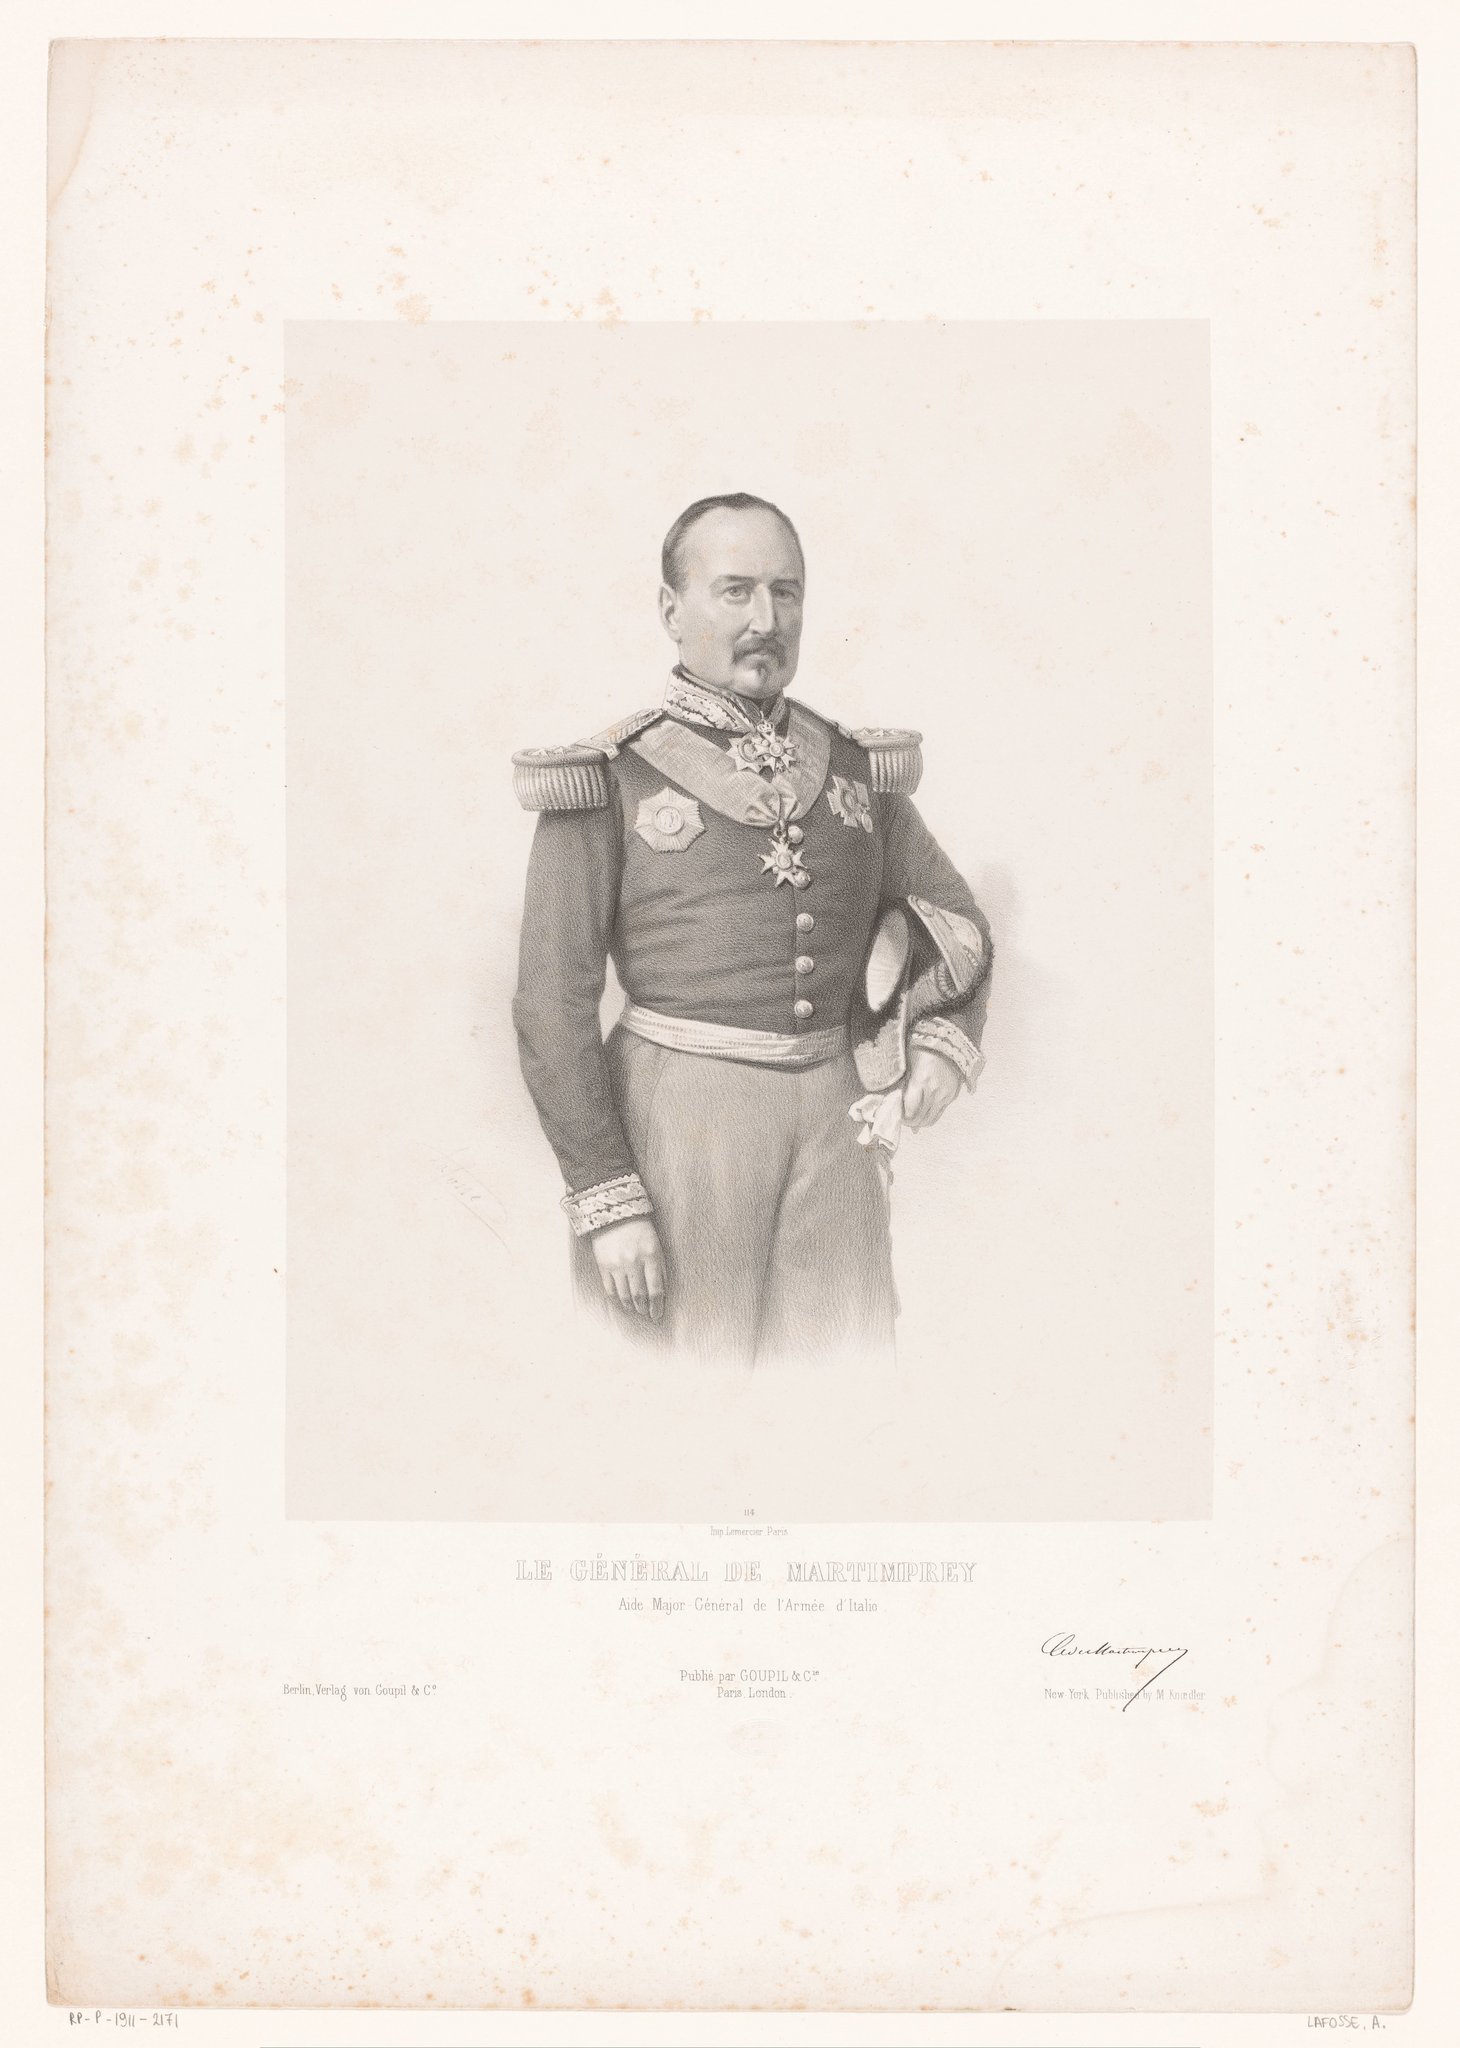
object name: print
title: Le Général de Martimprey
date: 1859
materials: paper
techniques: lithograph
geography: paris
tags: paris, politician, historical persons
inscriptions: collector's mark: Lugt 2228a, check stamp: Lugt 1090